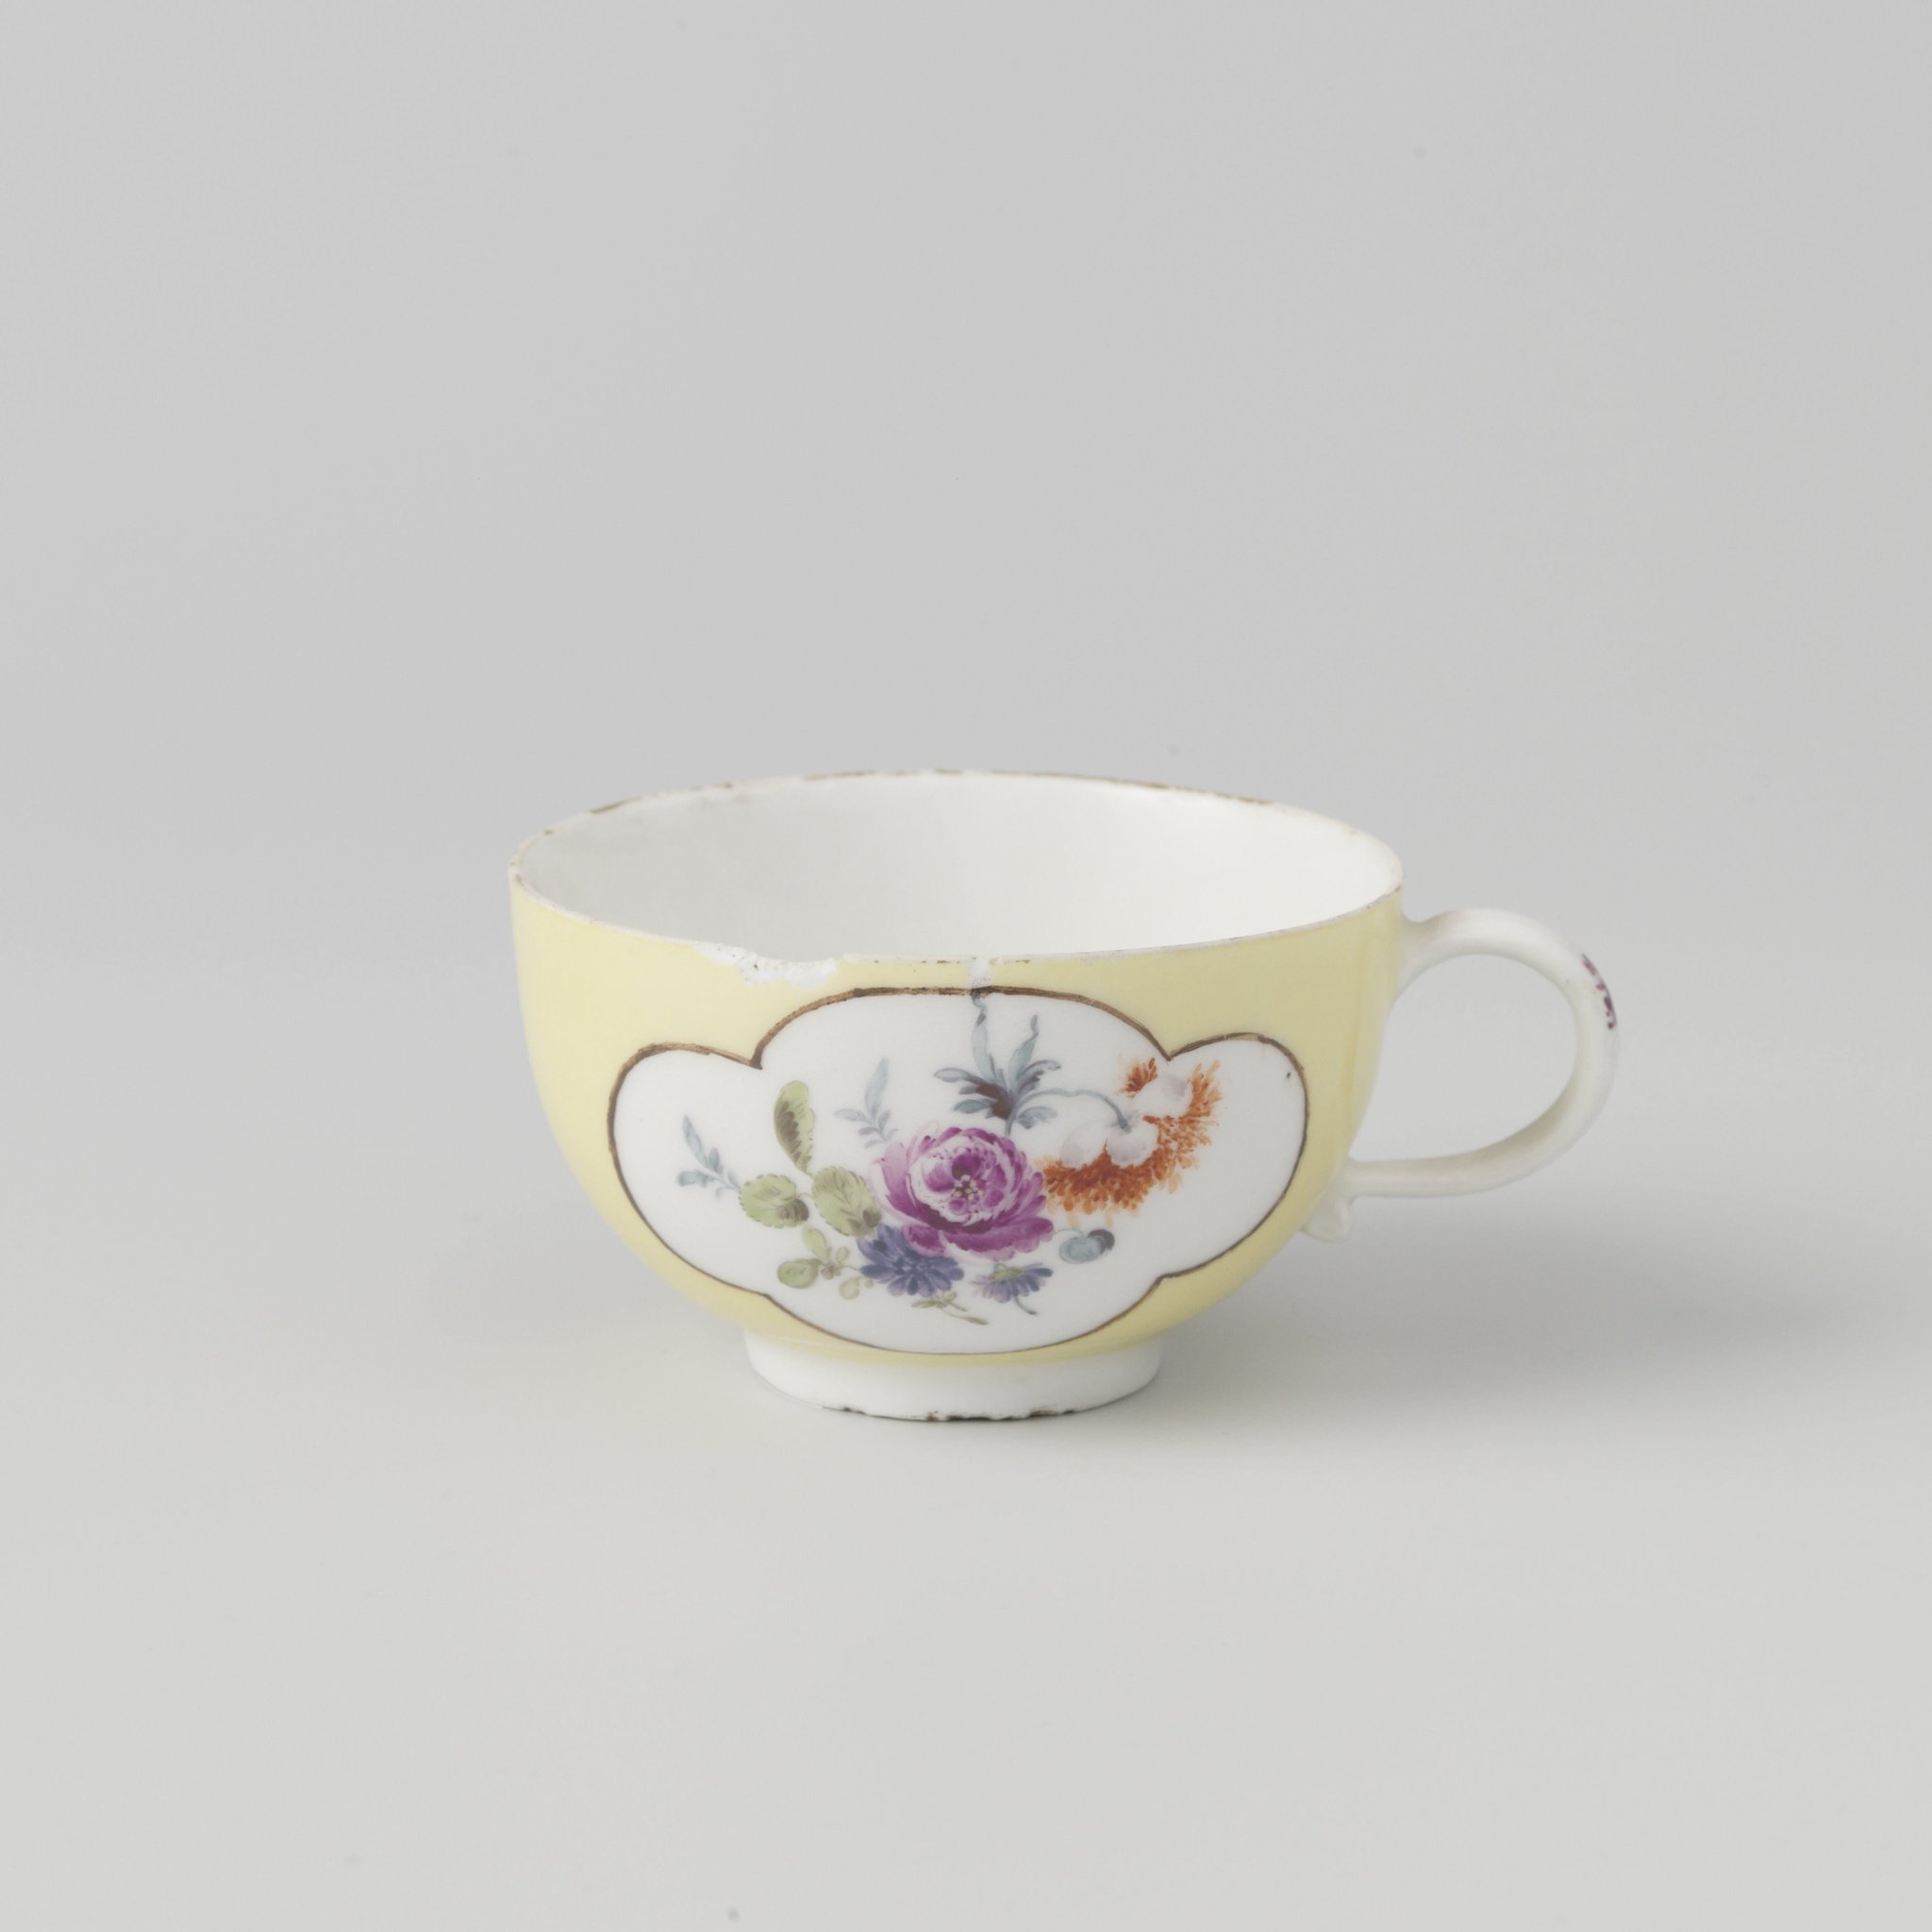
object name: eating drinking utensil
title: Kop, veelkleurig beschilderd met Deutsche Blumen in uitgespaarde vierpassen in een gele fond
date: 1765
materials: porcelain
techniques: painted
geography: meissen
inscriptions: mold mark: ‘66 (of 99)’, factory mark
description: Tea service. Porcelain. Meissen, c. 1770. Jonkvrouwe A.C.A.J. Clifford bequest, 1960.